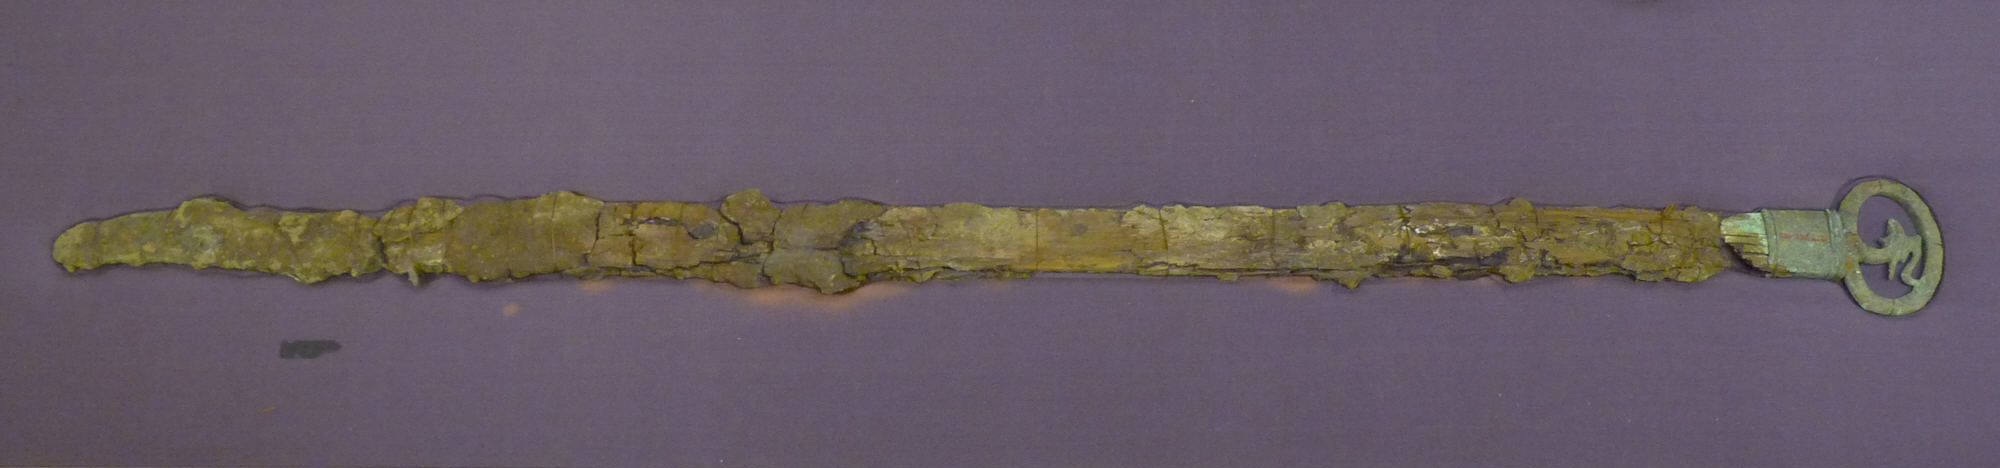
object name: sword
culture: japanese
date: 300-600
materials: gilt bronze, iron